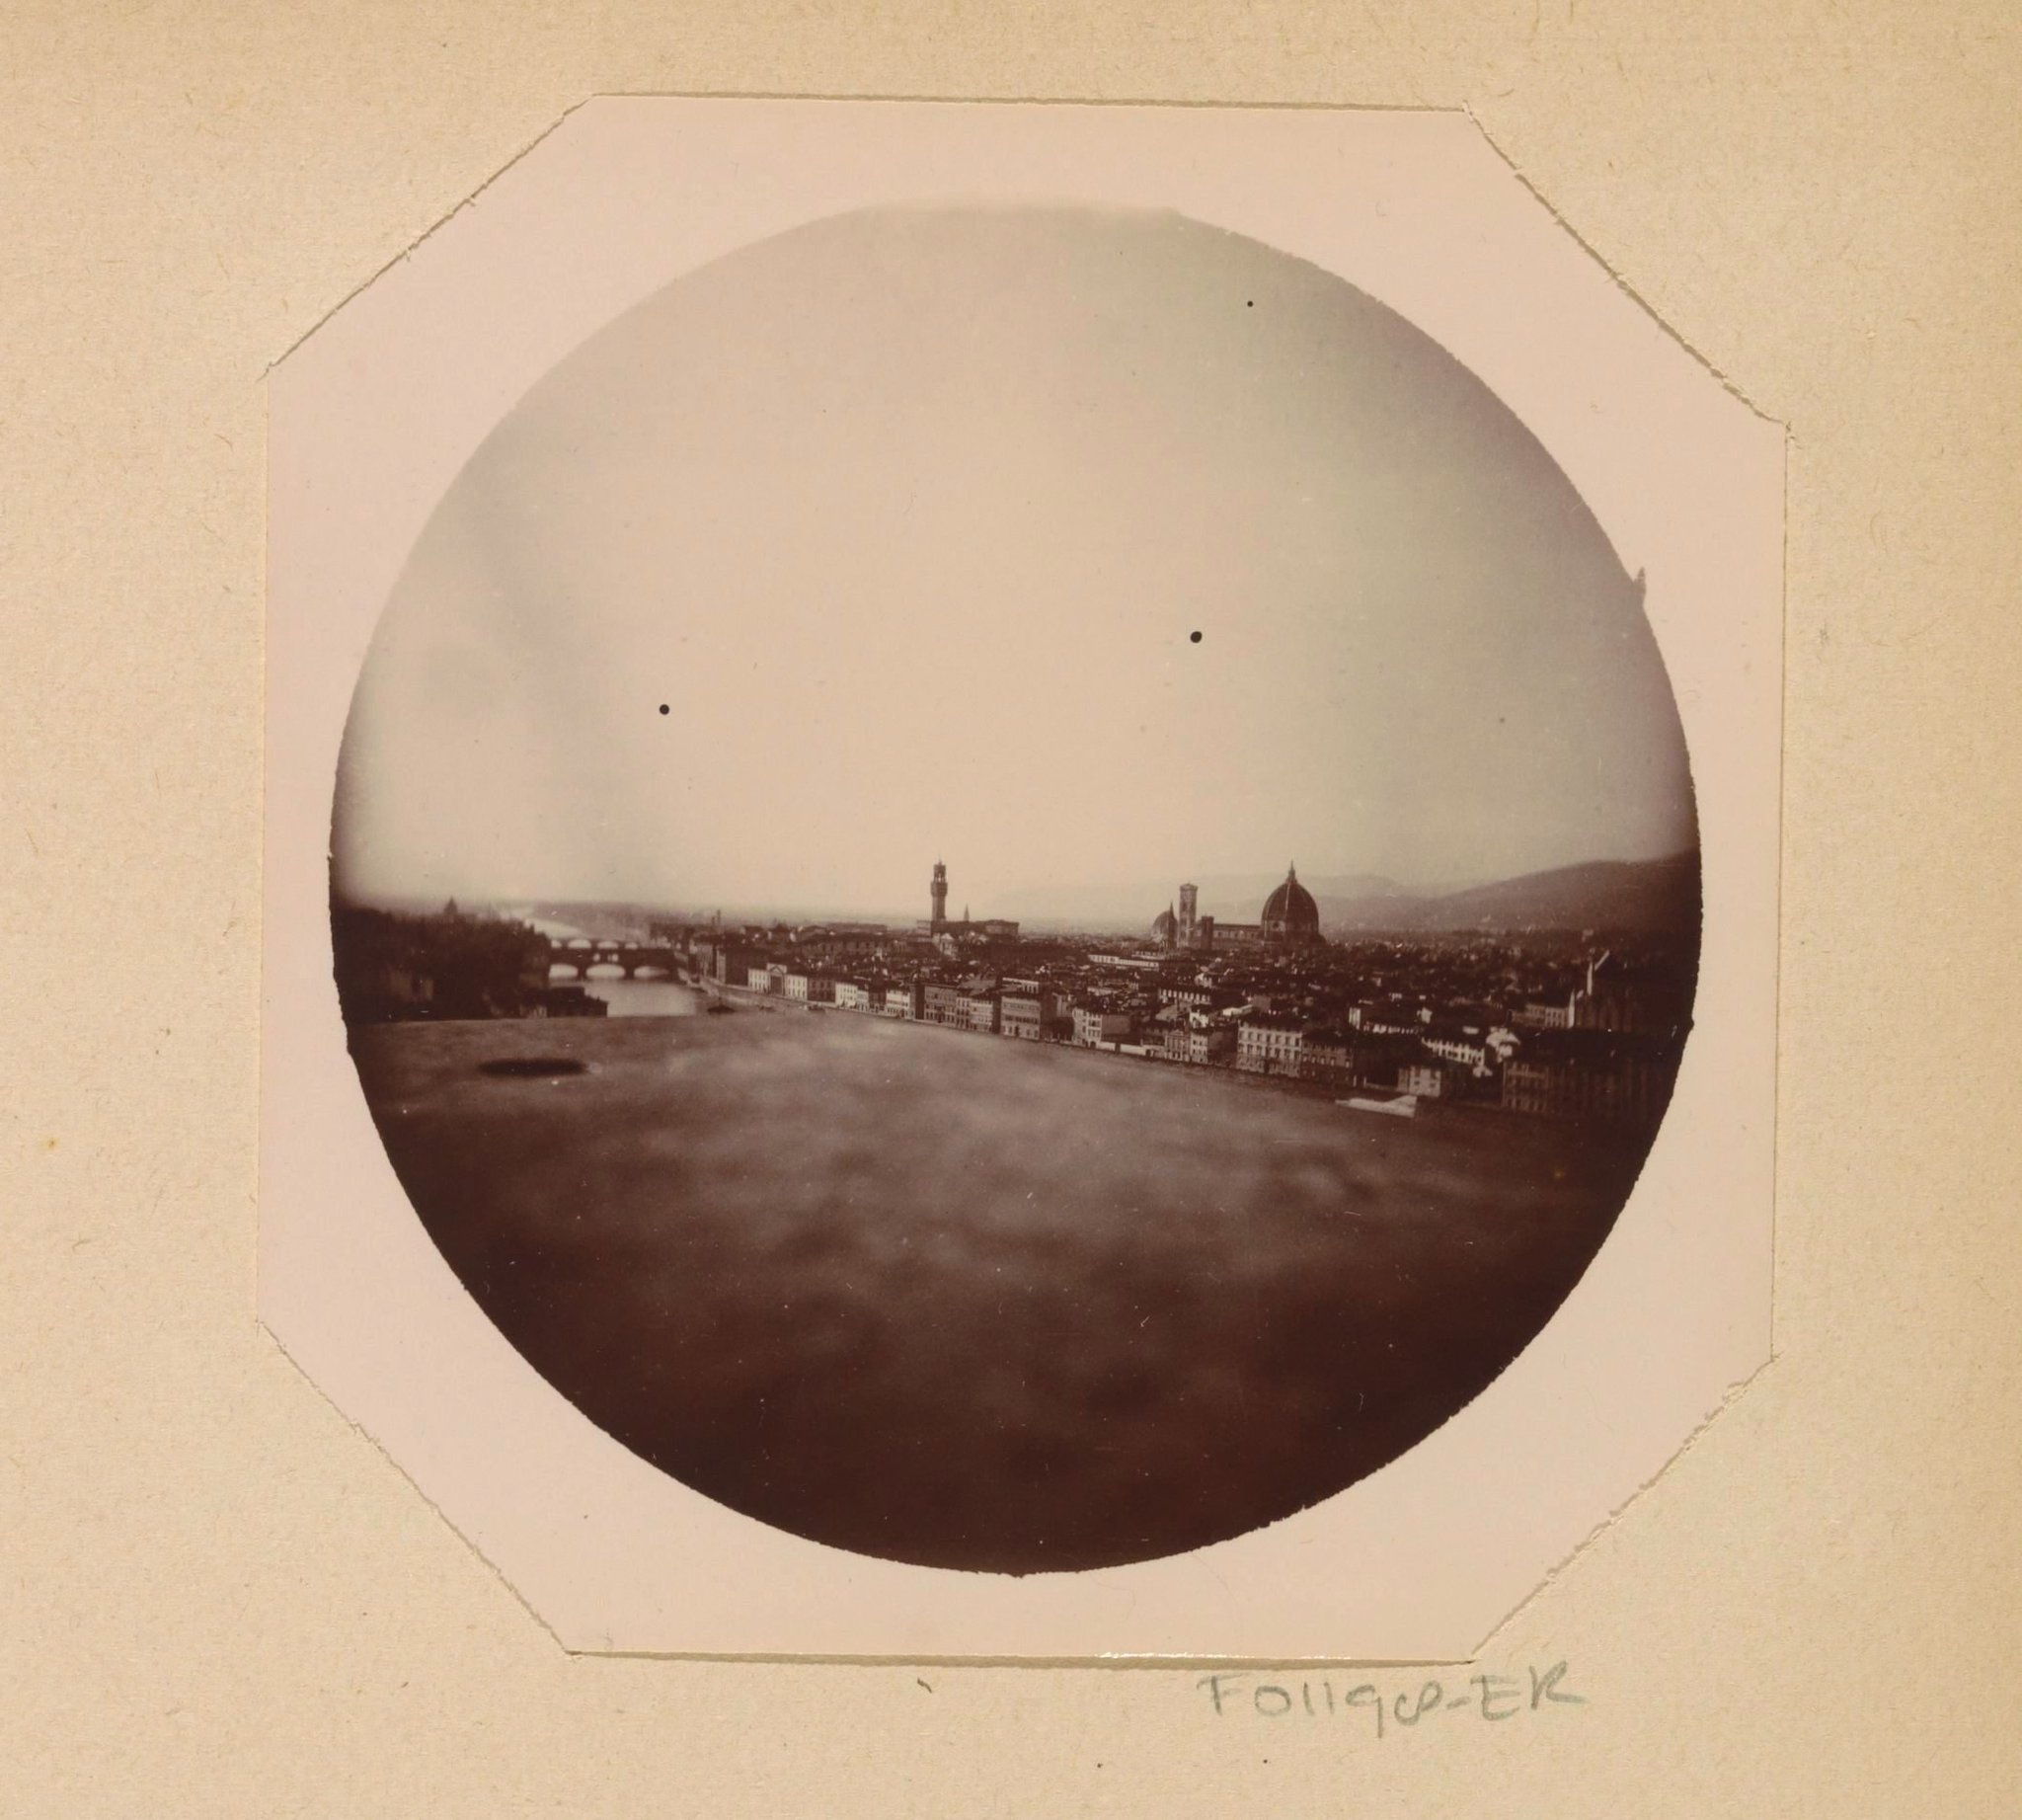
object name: photograph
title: Florence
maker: johanna margaretha piek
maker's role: fotograaf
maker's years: 1870-1947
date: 1889-1893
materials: paper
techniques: gelatin silver print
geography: florence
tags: city-view in general; 'veduta'